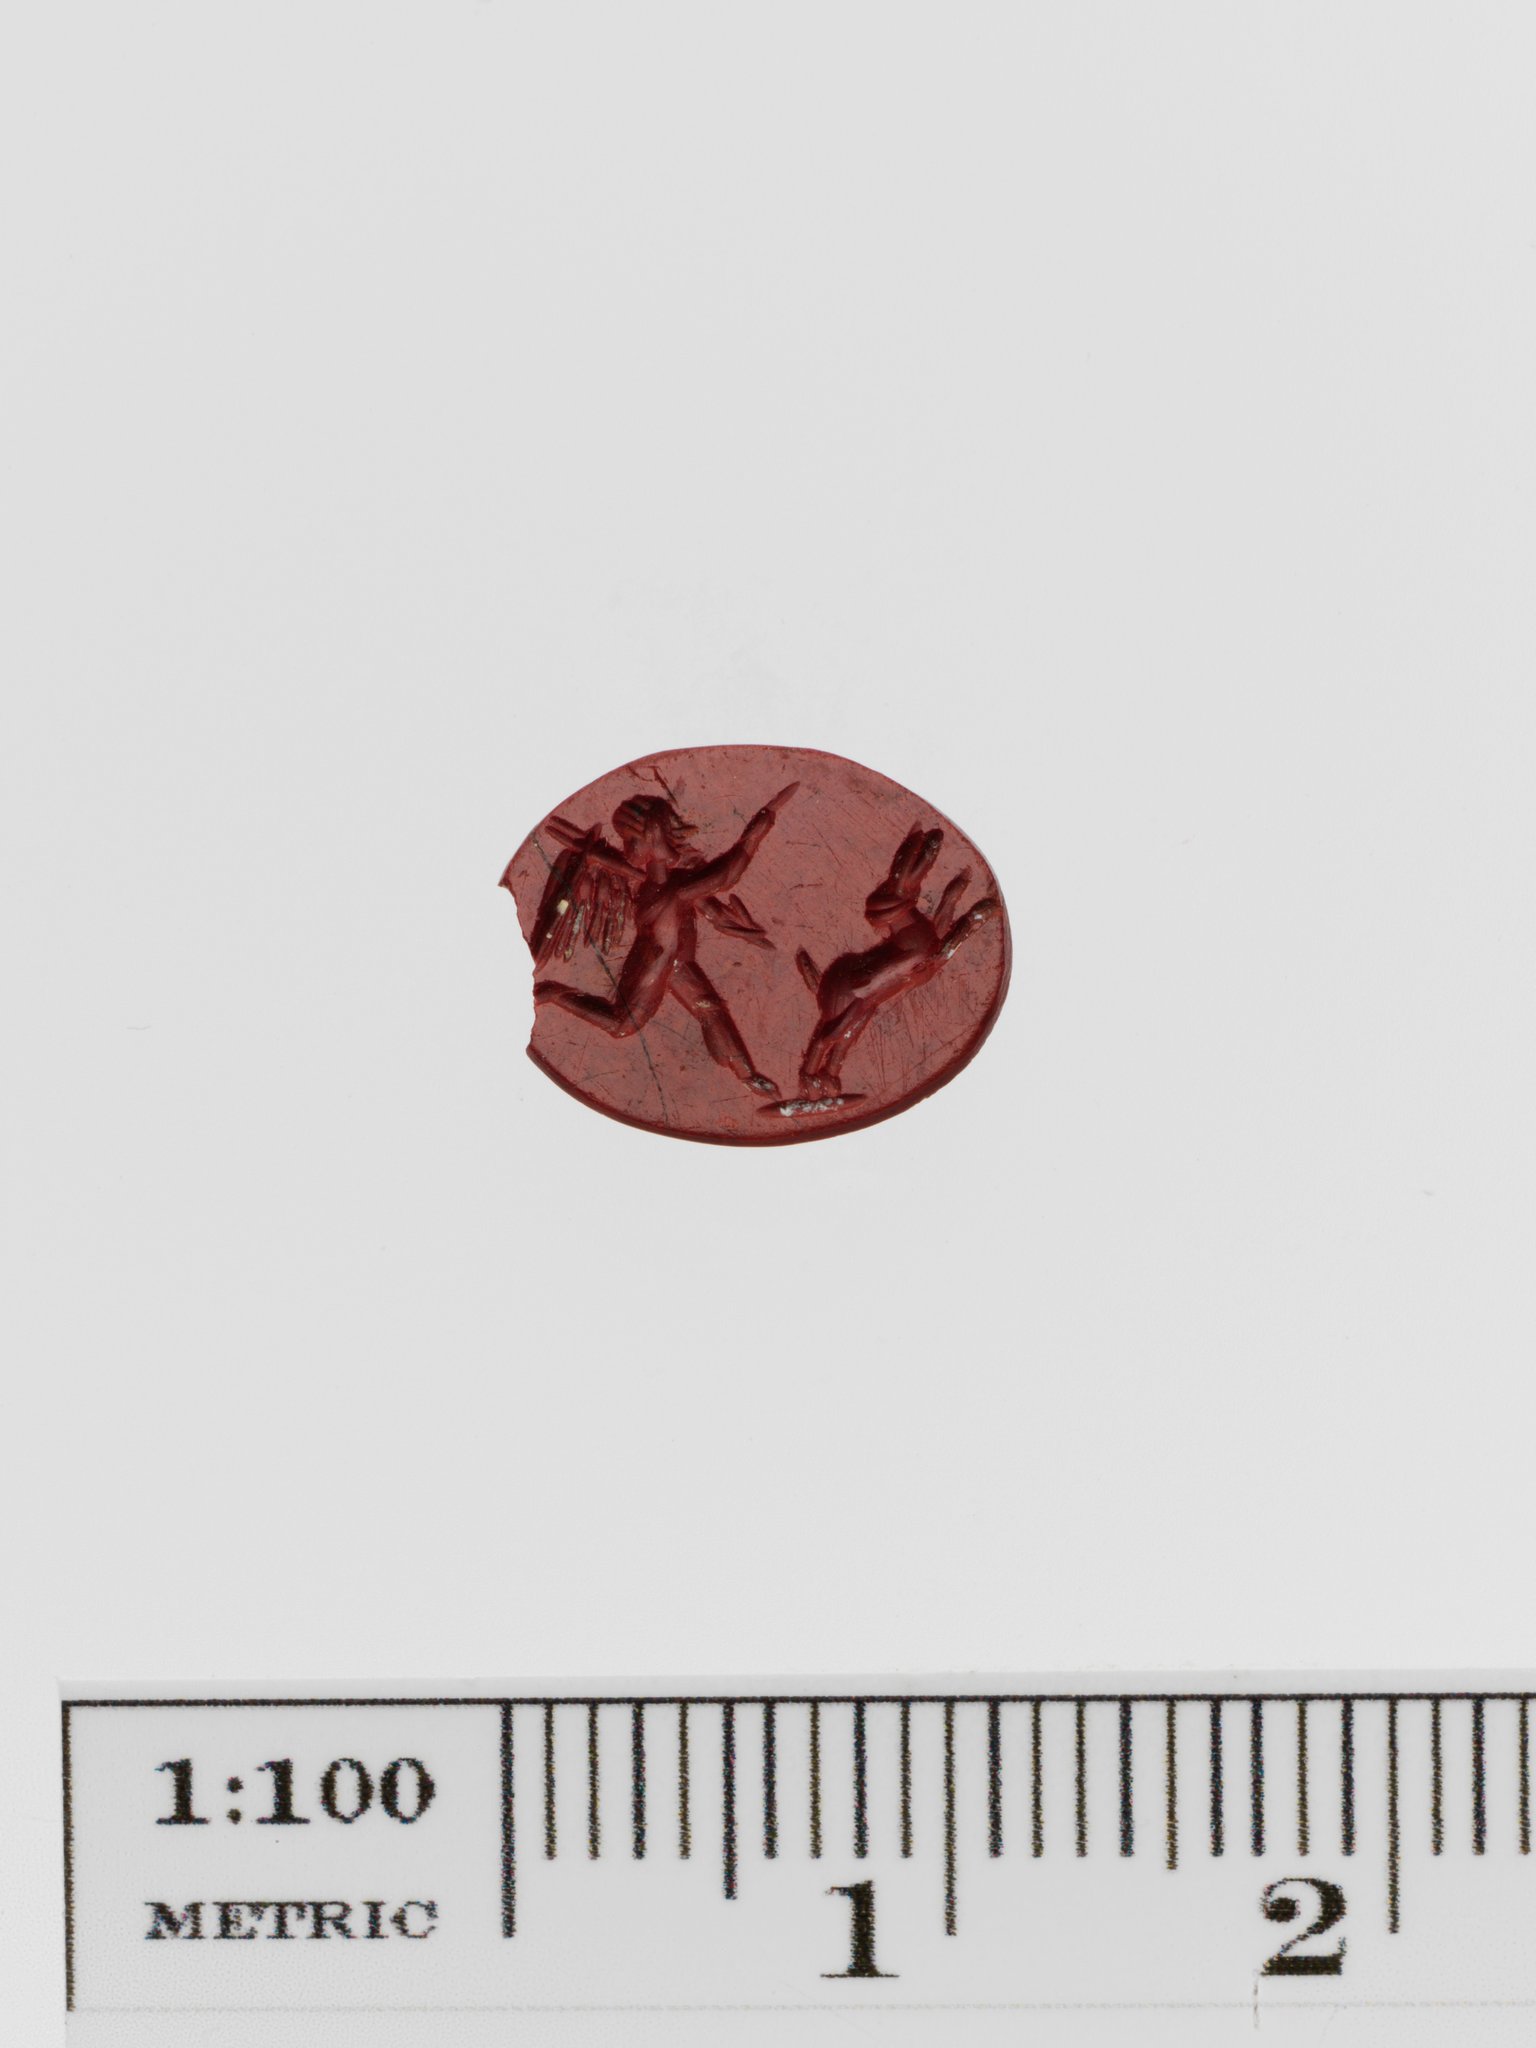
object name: intaglio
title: Red jasper ring stone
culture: roman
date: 100 BCE-300 CE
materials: jasper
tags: eros,rabbits